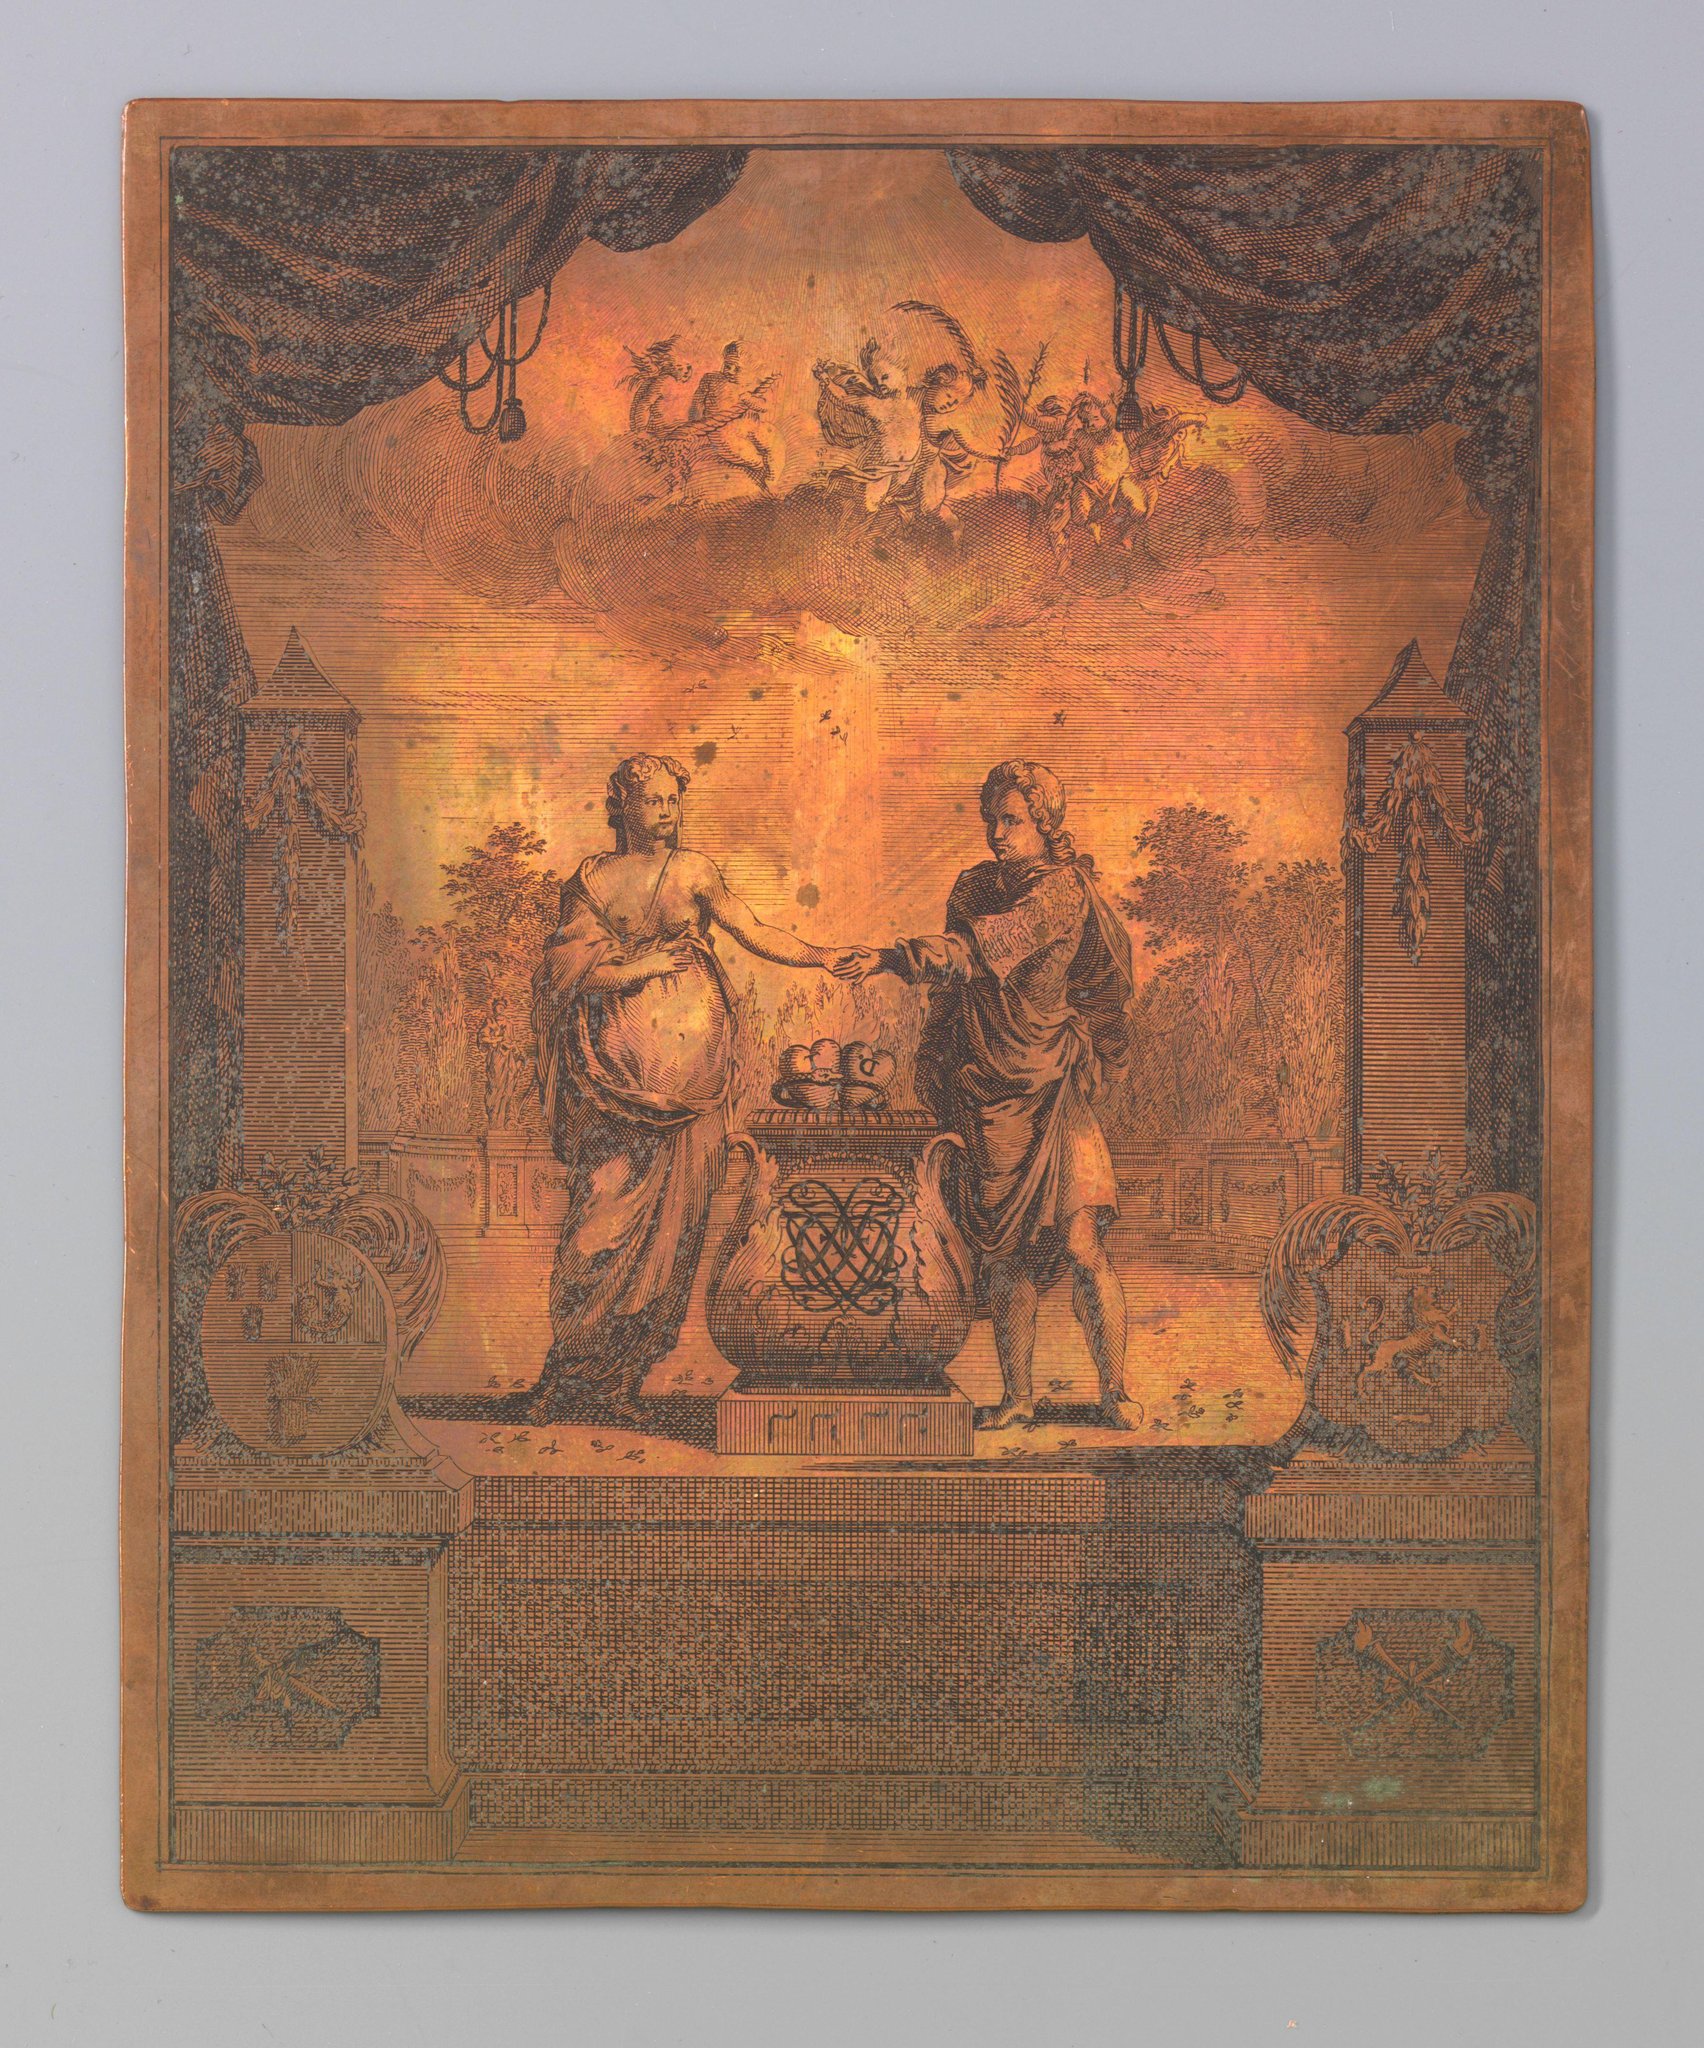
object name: copper plate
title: Huwelijksportret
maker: romeyn de hooghe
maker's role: draughtsman, goldsmith, painter, print maker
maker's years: 1645-1708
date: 1663-1683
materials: copper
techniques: etching